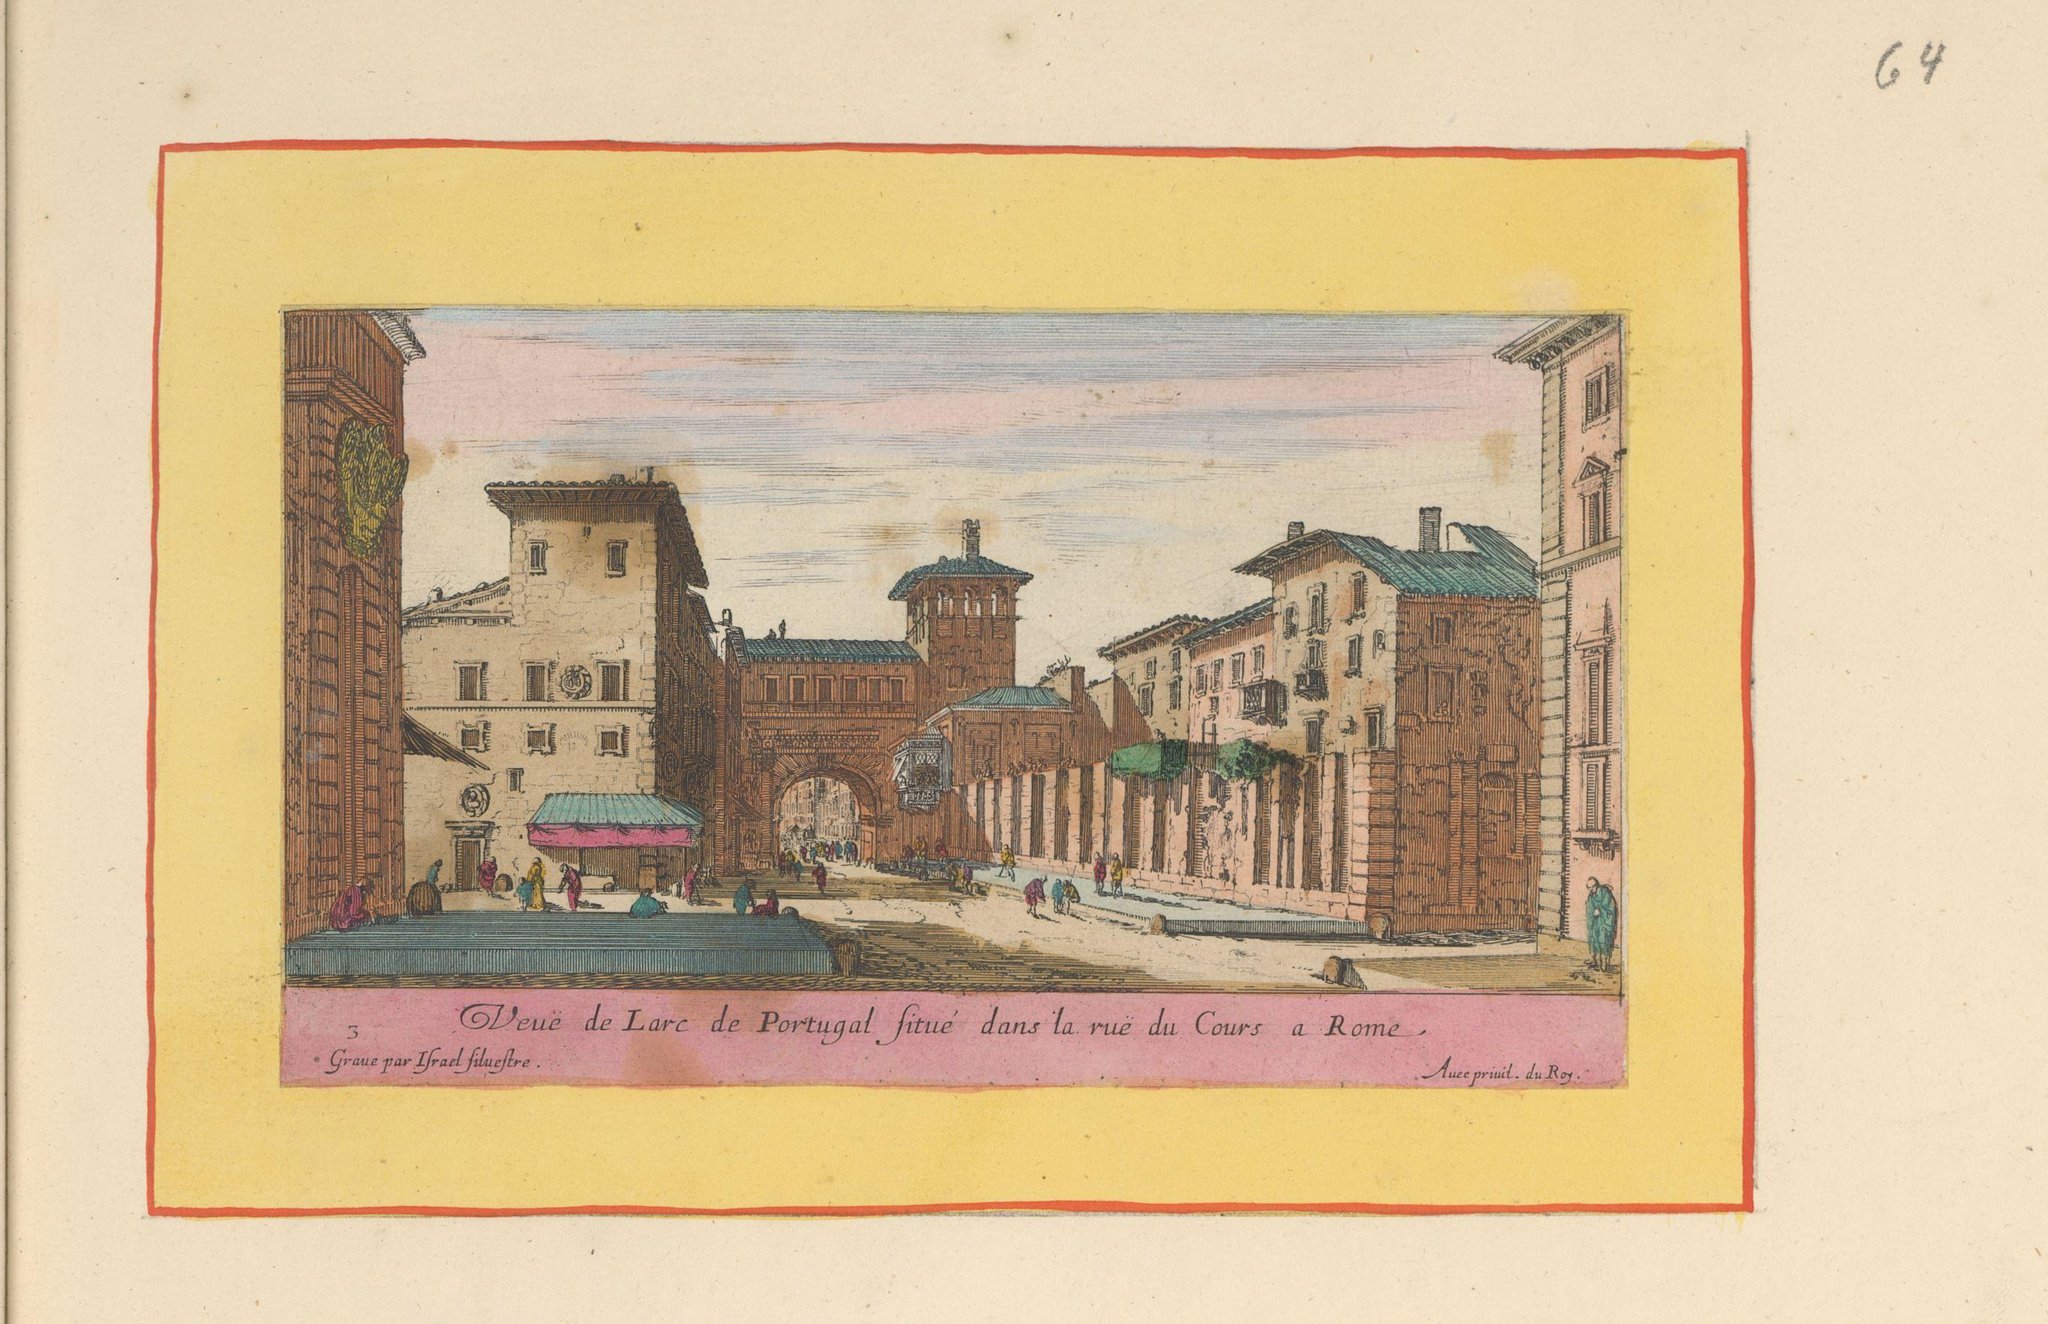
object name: album leaf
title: Veue de Larc de Portugal situe dans la rue du Cours a Rome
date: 1631-1691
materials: paper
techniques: colour, etching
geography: paris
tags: city-view, and landscape with man-made constructions, arch, archivolt ~ architecture, street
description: Gezicht op de Boog van Portugal in de Via del Corso te Rome. Titel in het Frans in de ondermarge. Prent maakt deel uit van een album.